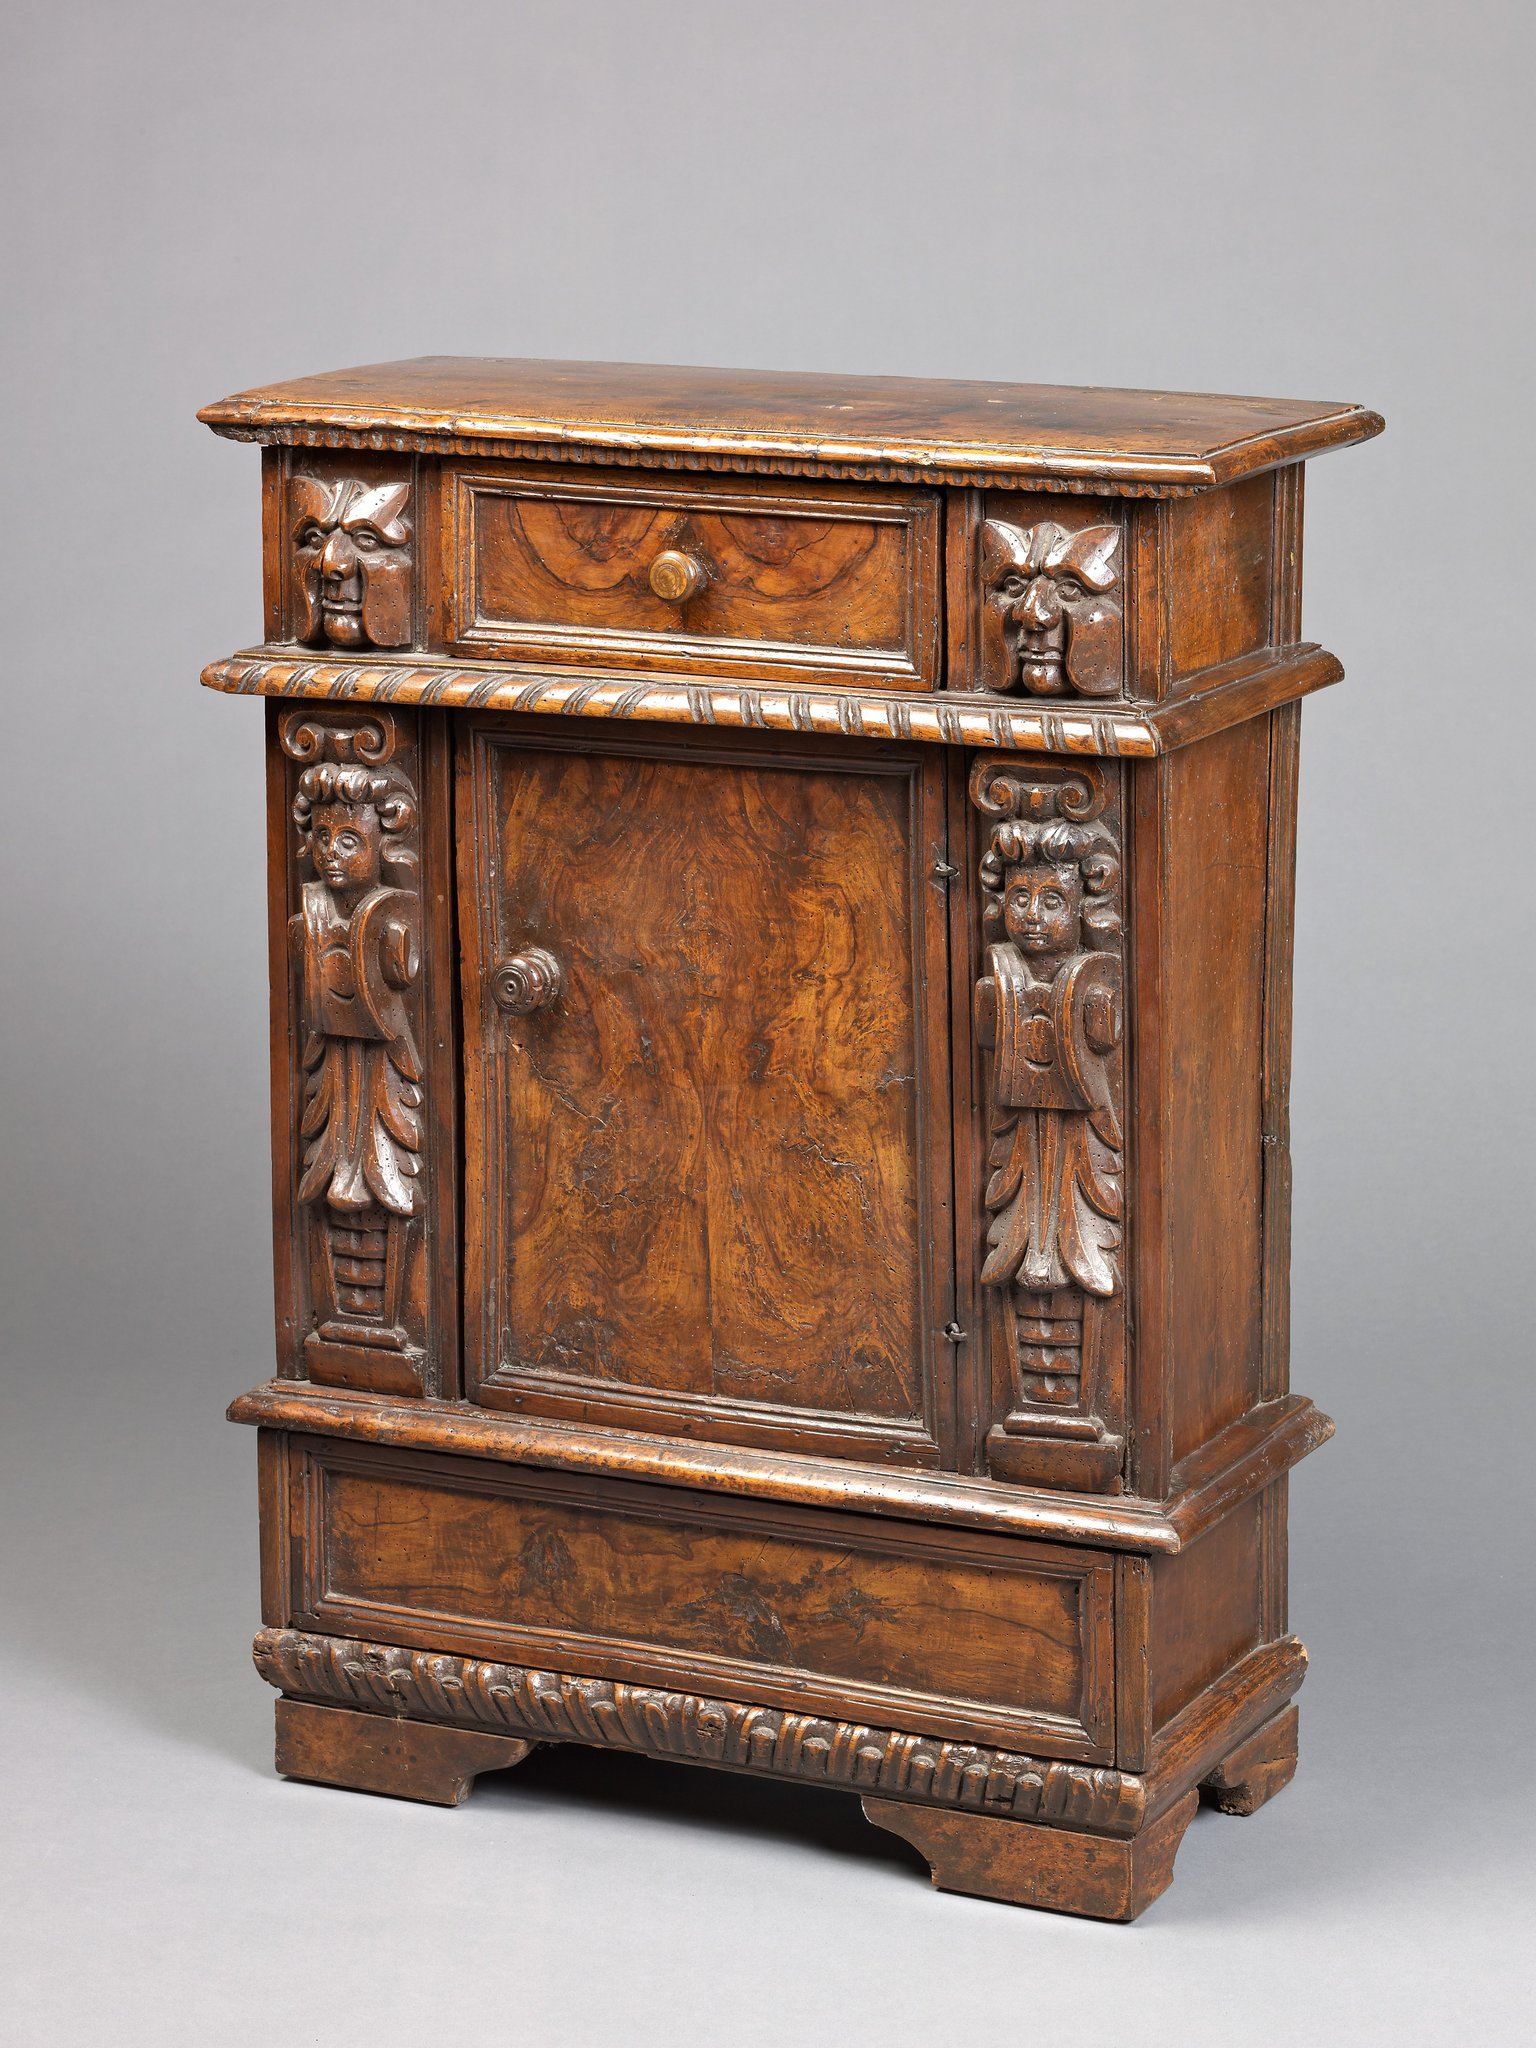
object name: cabinet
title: Small cabinet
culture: italian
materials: wood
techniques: carving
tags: masks,caryatids